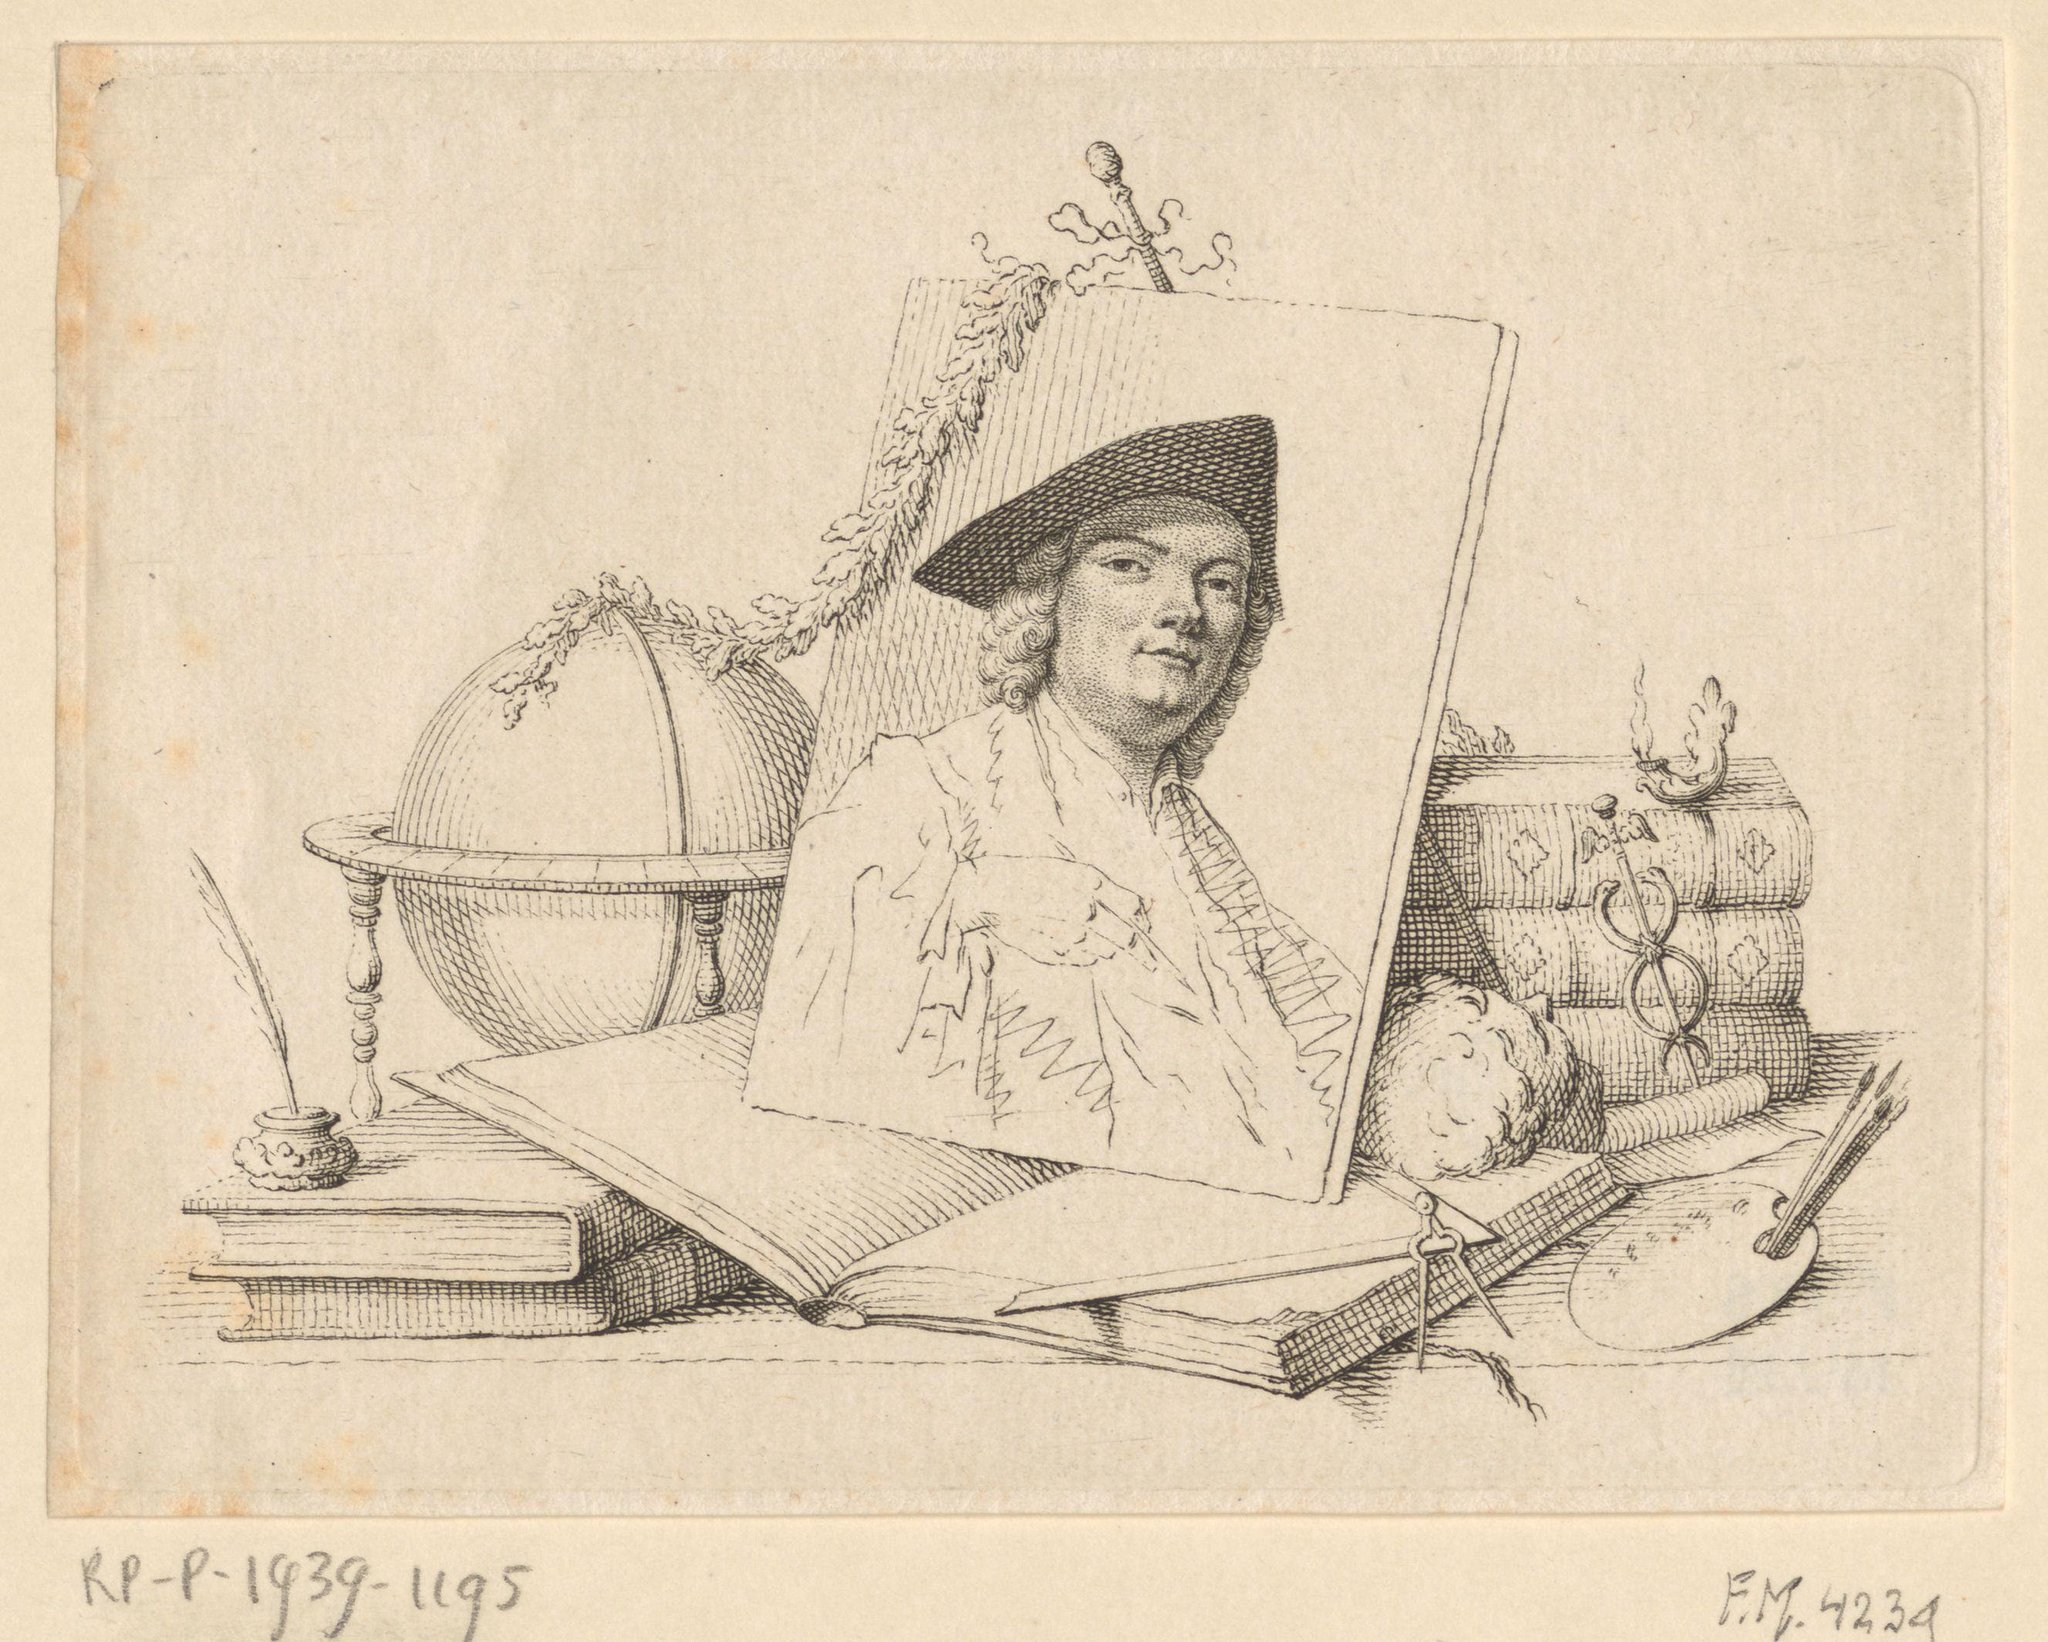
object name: print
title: Portret van Cornelis Ploos van Amstel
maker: jacob van der schley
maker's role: draughtsman, print maker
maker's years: 1715-1779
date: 1758-1779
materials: paper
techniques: etching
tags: cornelis ploos van amstel, writing tools, historical persons, book, caduceus (staff with two snakes, attribute of mercury), globe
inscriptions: collector's mark: Lugt 2166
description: Het portret van Cornelis Ploos van Amstel op een schilderdoek. Naast het portret een globe, boeken, schrijfgerei, schilder- en graveergereedschap, een gebeeldhouwde kop en de mercuriusstaf.